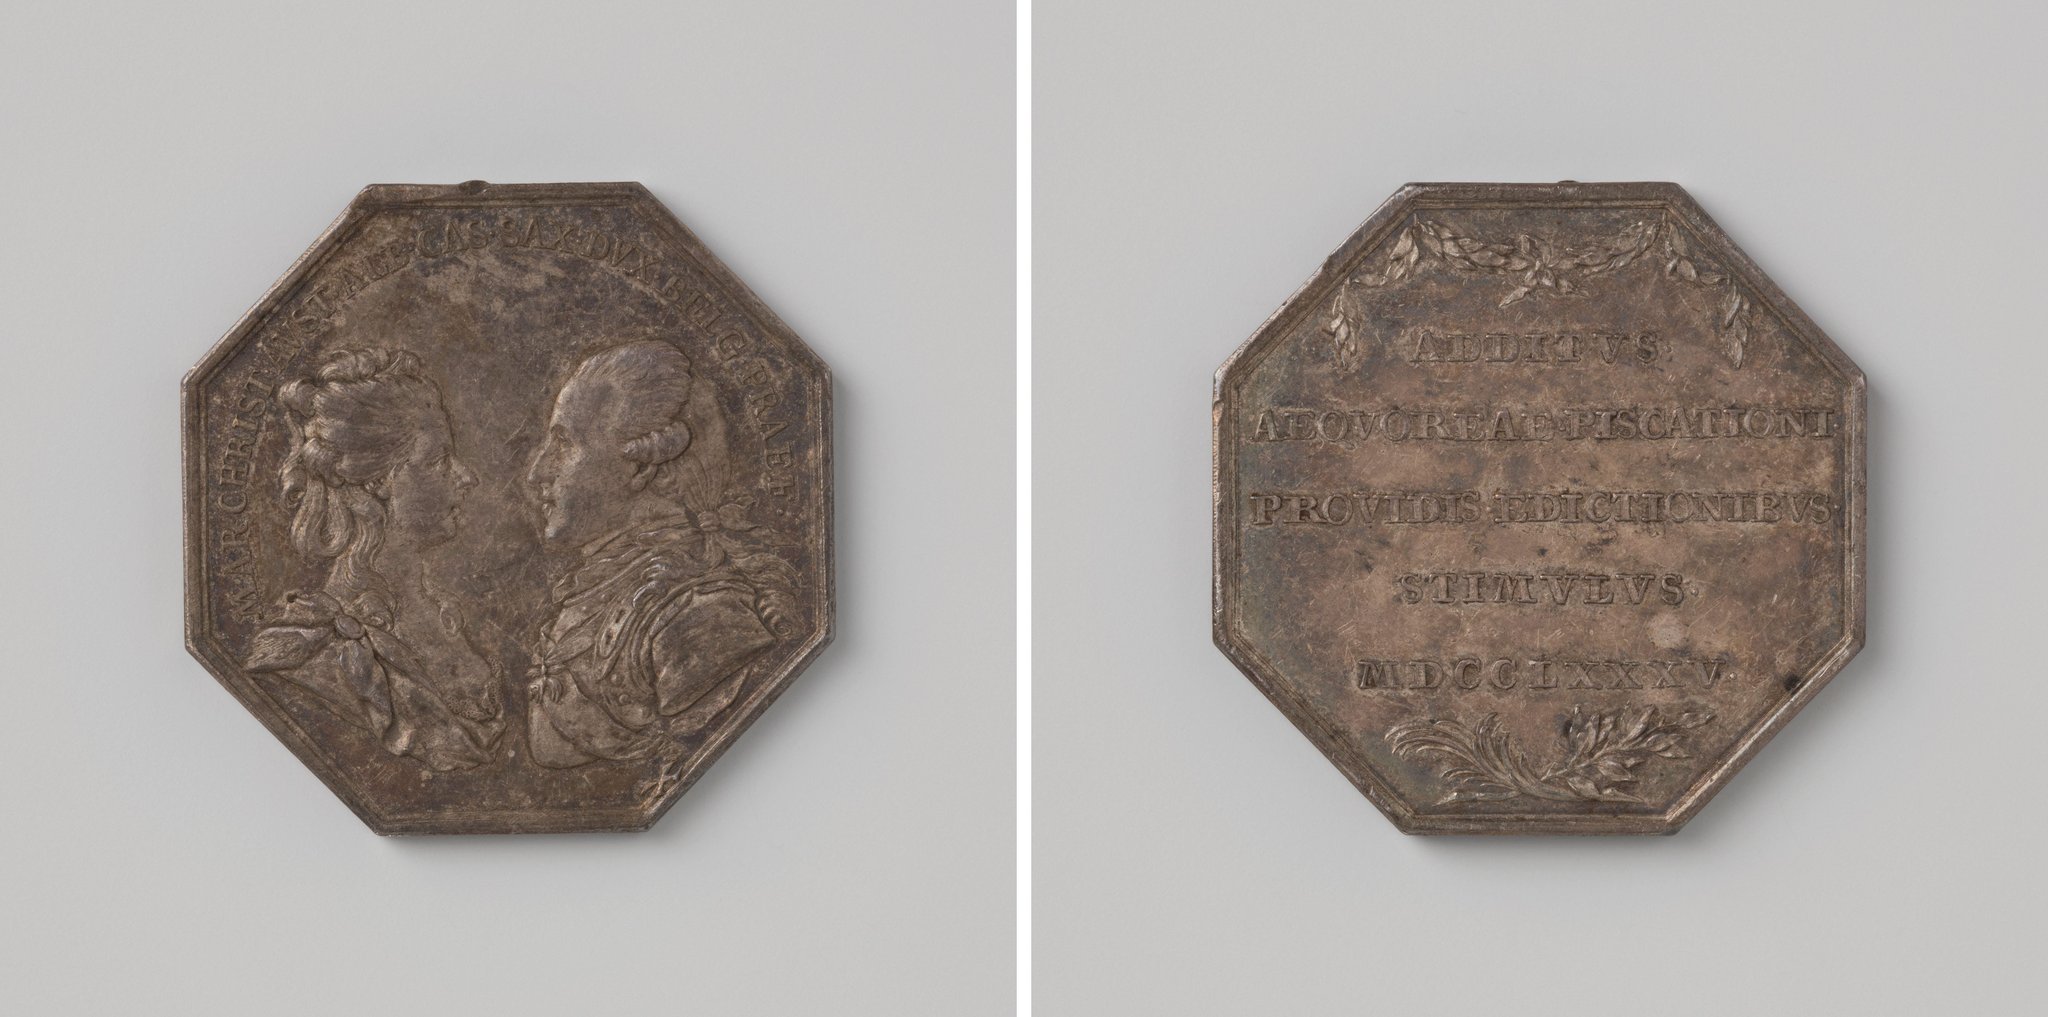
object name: history medal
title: De Schelde geopend door de vrede van Fontainebleau, ter ere van Maria Christina en Albert-Kasimir, landvoogden der zuidelijke Nederlanden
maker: theodorus victor van berckel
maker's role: mintmaster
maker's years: 1739-1808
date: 1785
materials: silver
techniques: striking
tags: albert casimir van saksen-teschen, vienna, maria christina van oostenrijk (1742-1798)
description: Zilveren achthoekige penning. Voorzijde: naar elkaar gewende borststukken van man en vrouw binnen omschrift. Keerzijde: opschrift onder guirlande, boven gekruiste palm- en olijftak